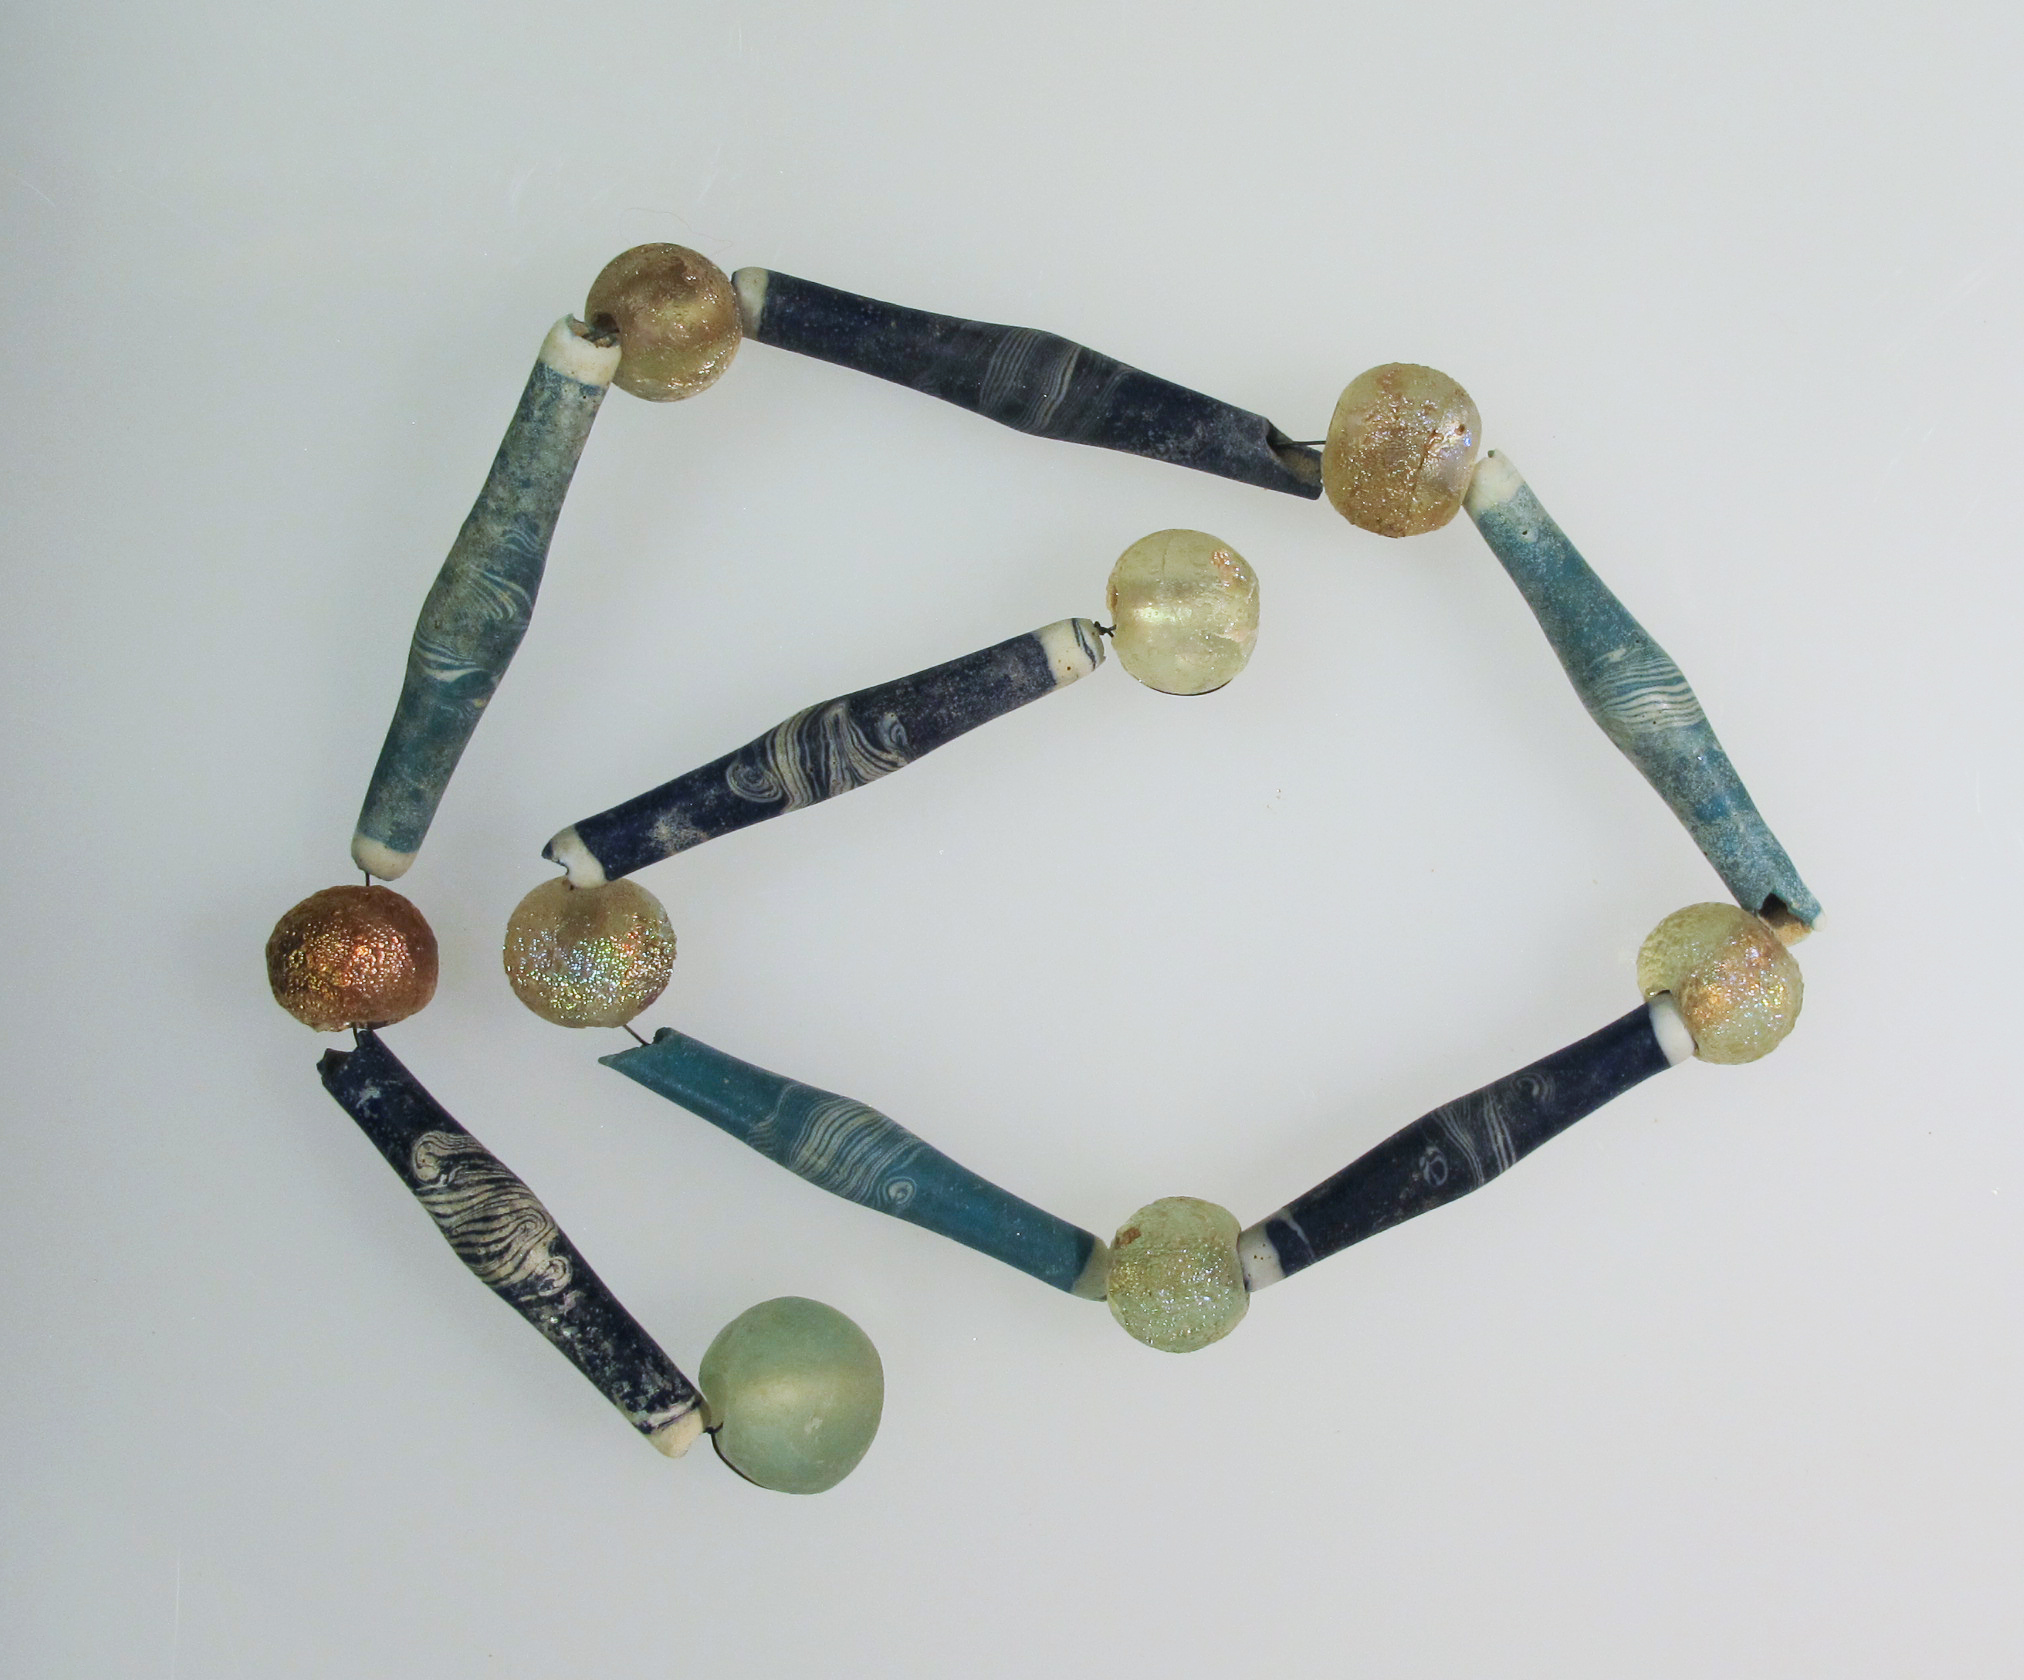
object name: necklace with 15 bead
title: Necklace with 15 beads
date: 7000 BCE-330 CE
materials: glass